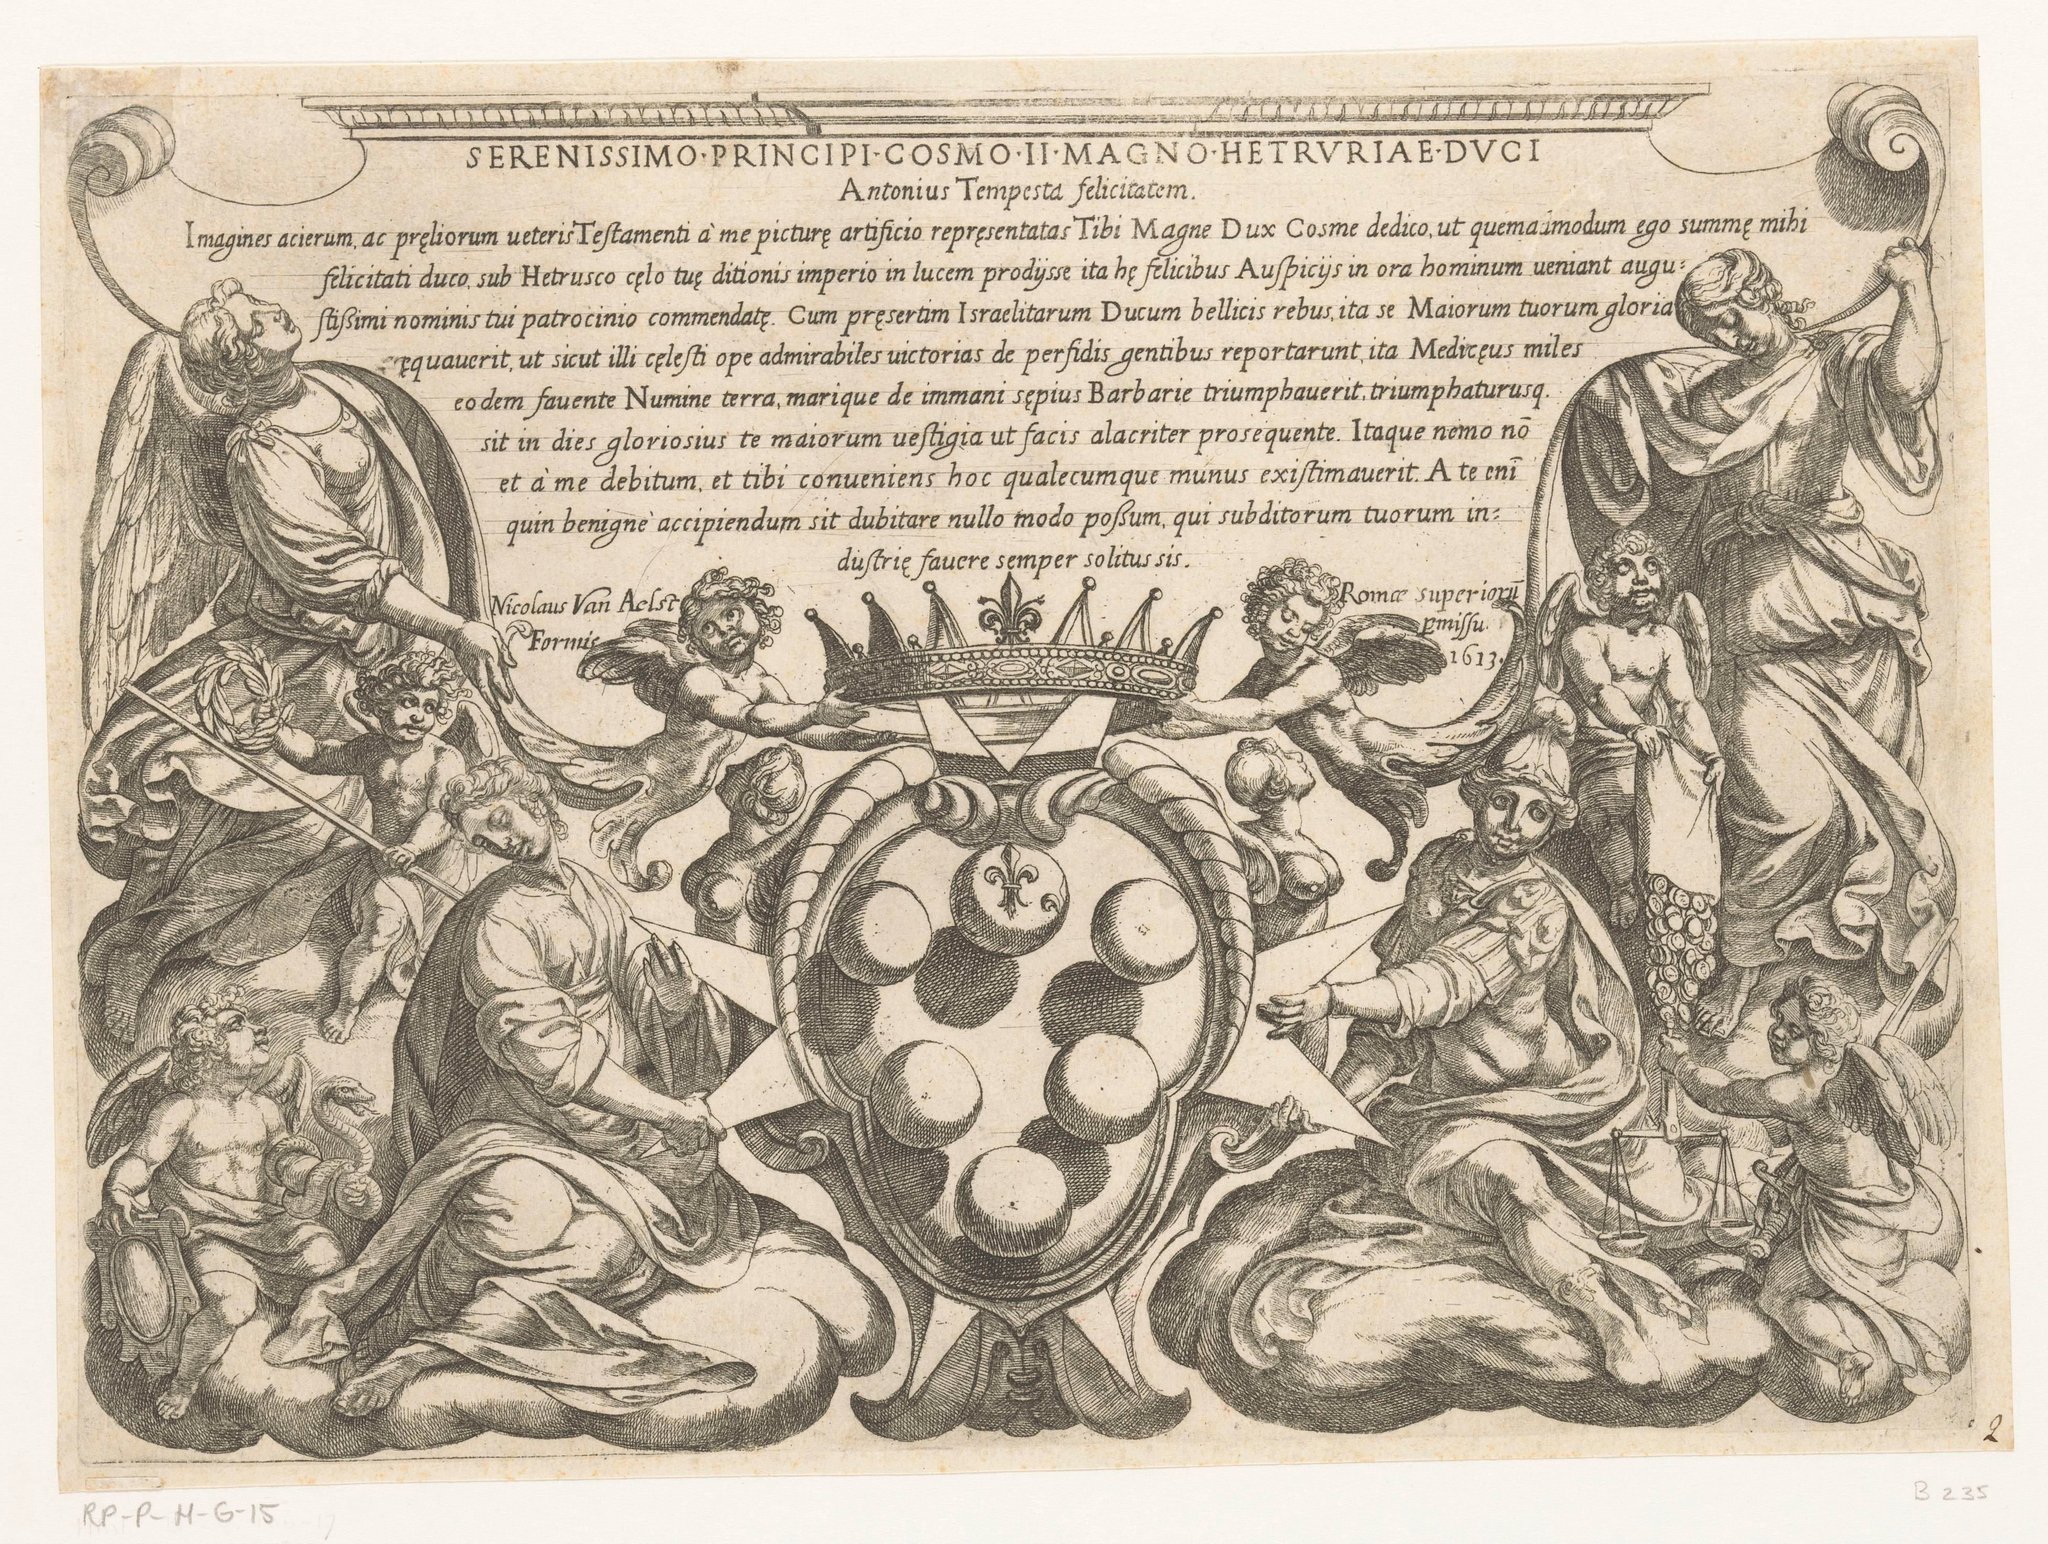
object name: print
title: Titelprent met opdracht aan en wapen van Cosimo II de'Medici en voorstellingen van Rechtvaardigheid, Voorzichtigheid, Roem en Edelmoedigheid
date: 1613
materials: paper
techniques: etching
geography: italy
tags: coat of arms (symbol of sovereignty), justitia (justice) as roman personification, fama as roman personification, generosity, liberality; 'generosità', 'liberalità' (ripa), cupids: 'amores', 'amoretti', 'putti', prudentia (prudence) as roman personification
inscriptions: number: ‘2’, collector's mark: ‘Hinloopen’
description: Titelprent bij een reeks van 24 prenten met oudtestamentische strijdscènes.